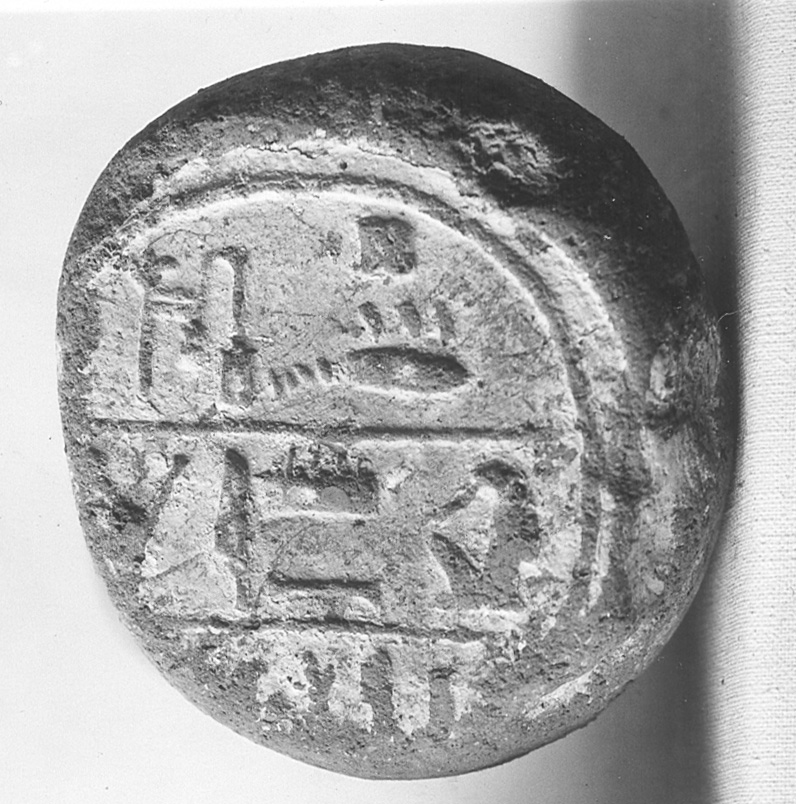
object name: cone, circular impression, djeserka, scribe of account, granary of amun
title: Funerary Cone of Djeserka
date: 1550-1352 BCE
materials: pottery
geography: egypt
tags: hieroglyphs